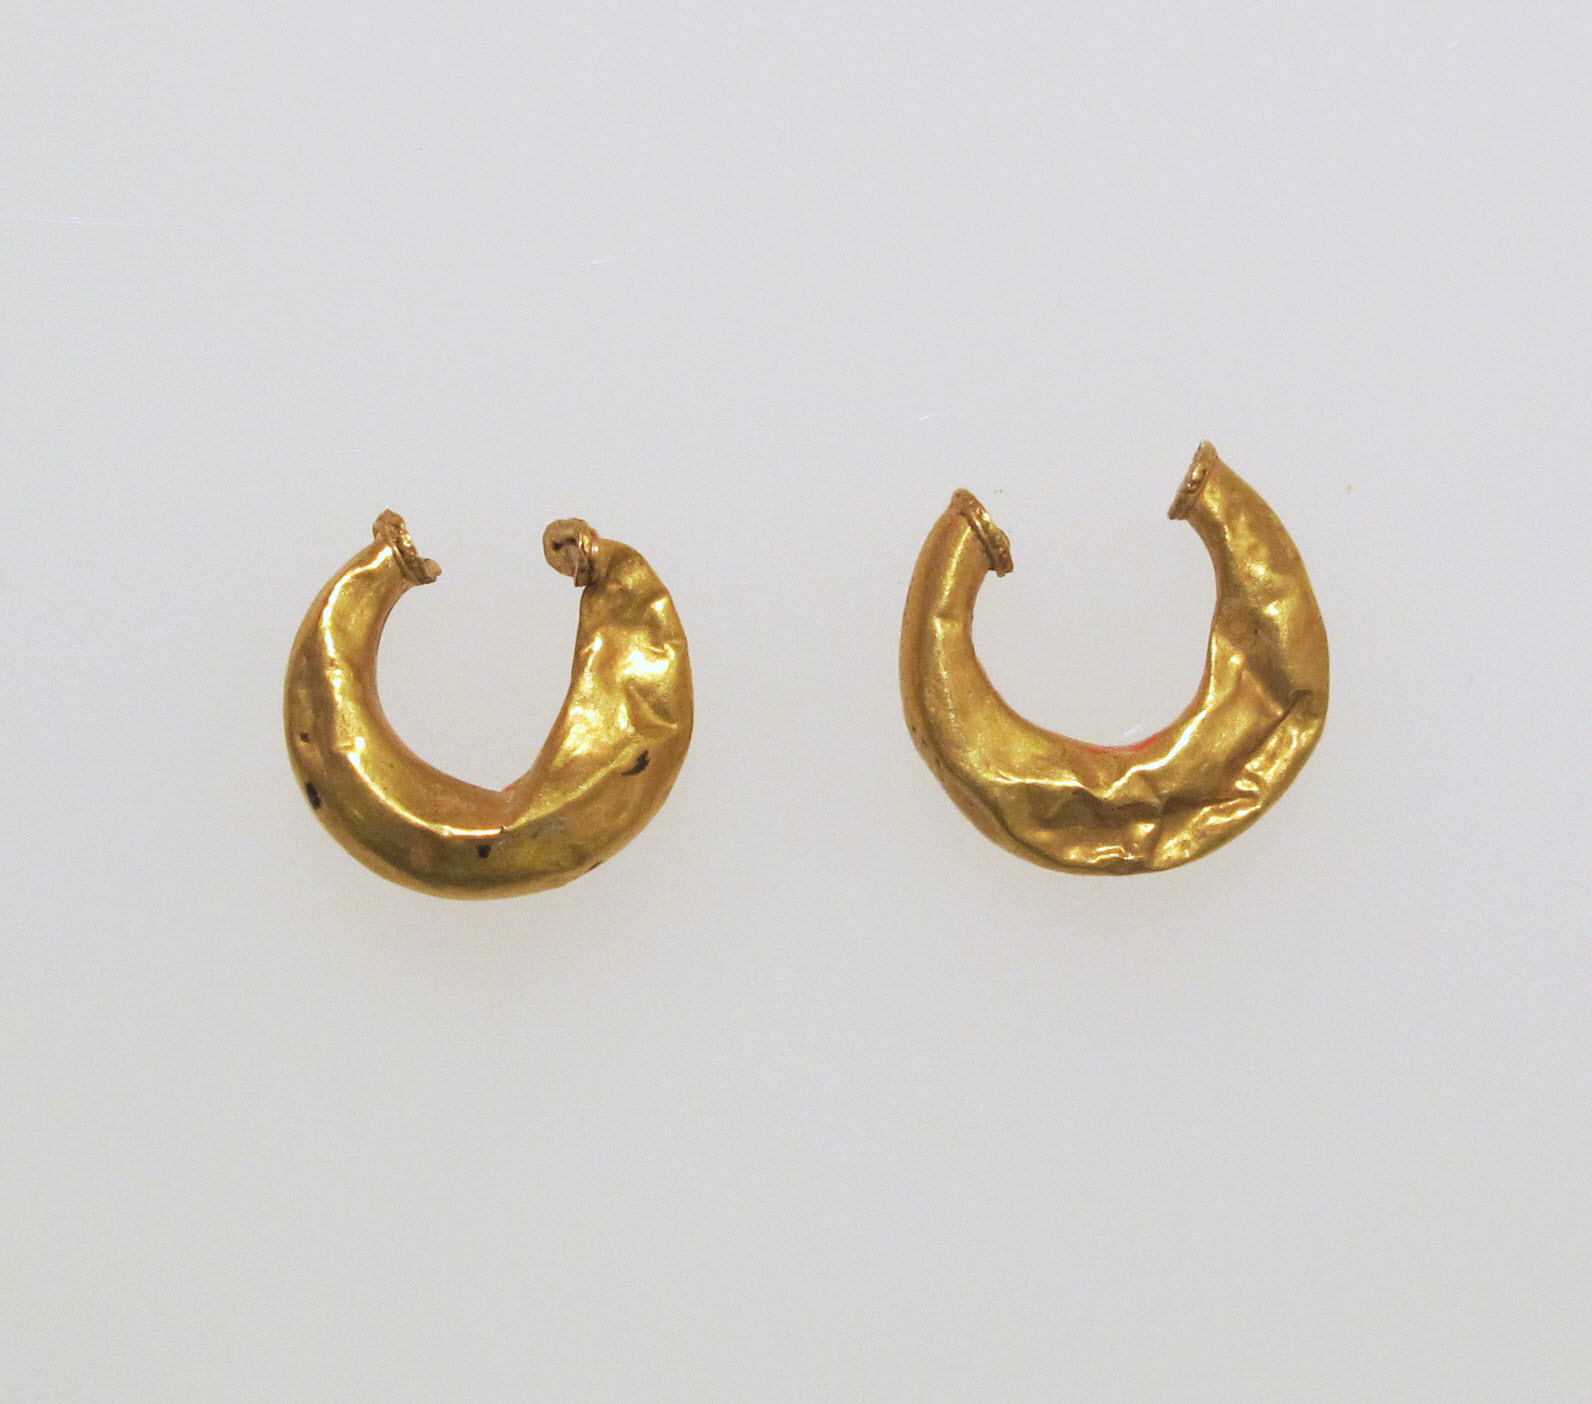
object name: earring, crescent shaped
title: Earring, crescent-shaped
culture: etruscan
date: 500-301 BCE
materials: gold